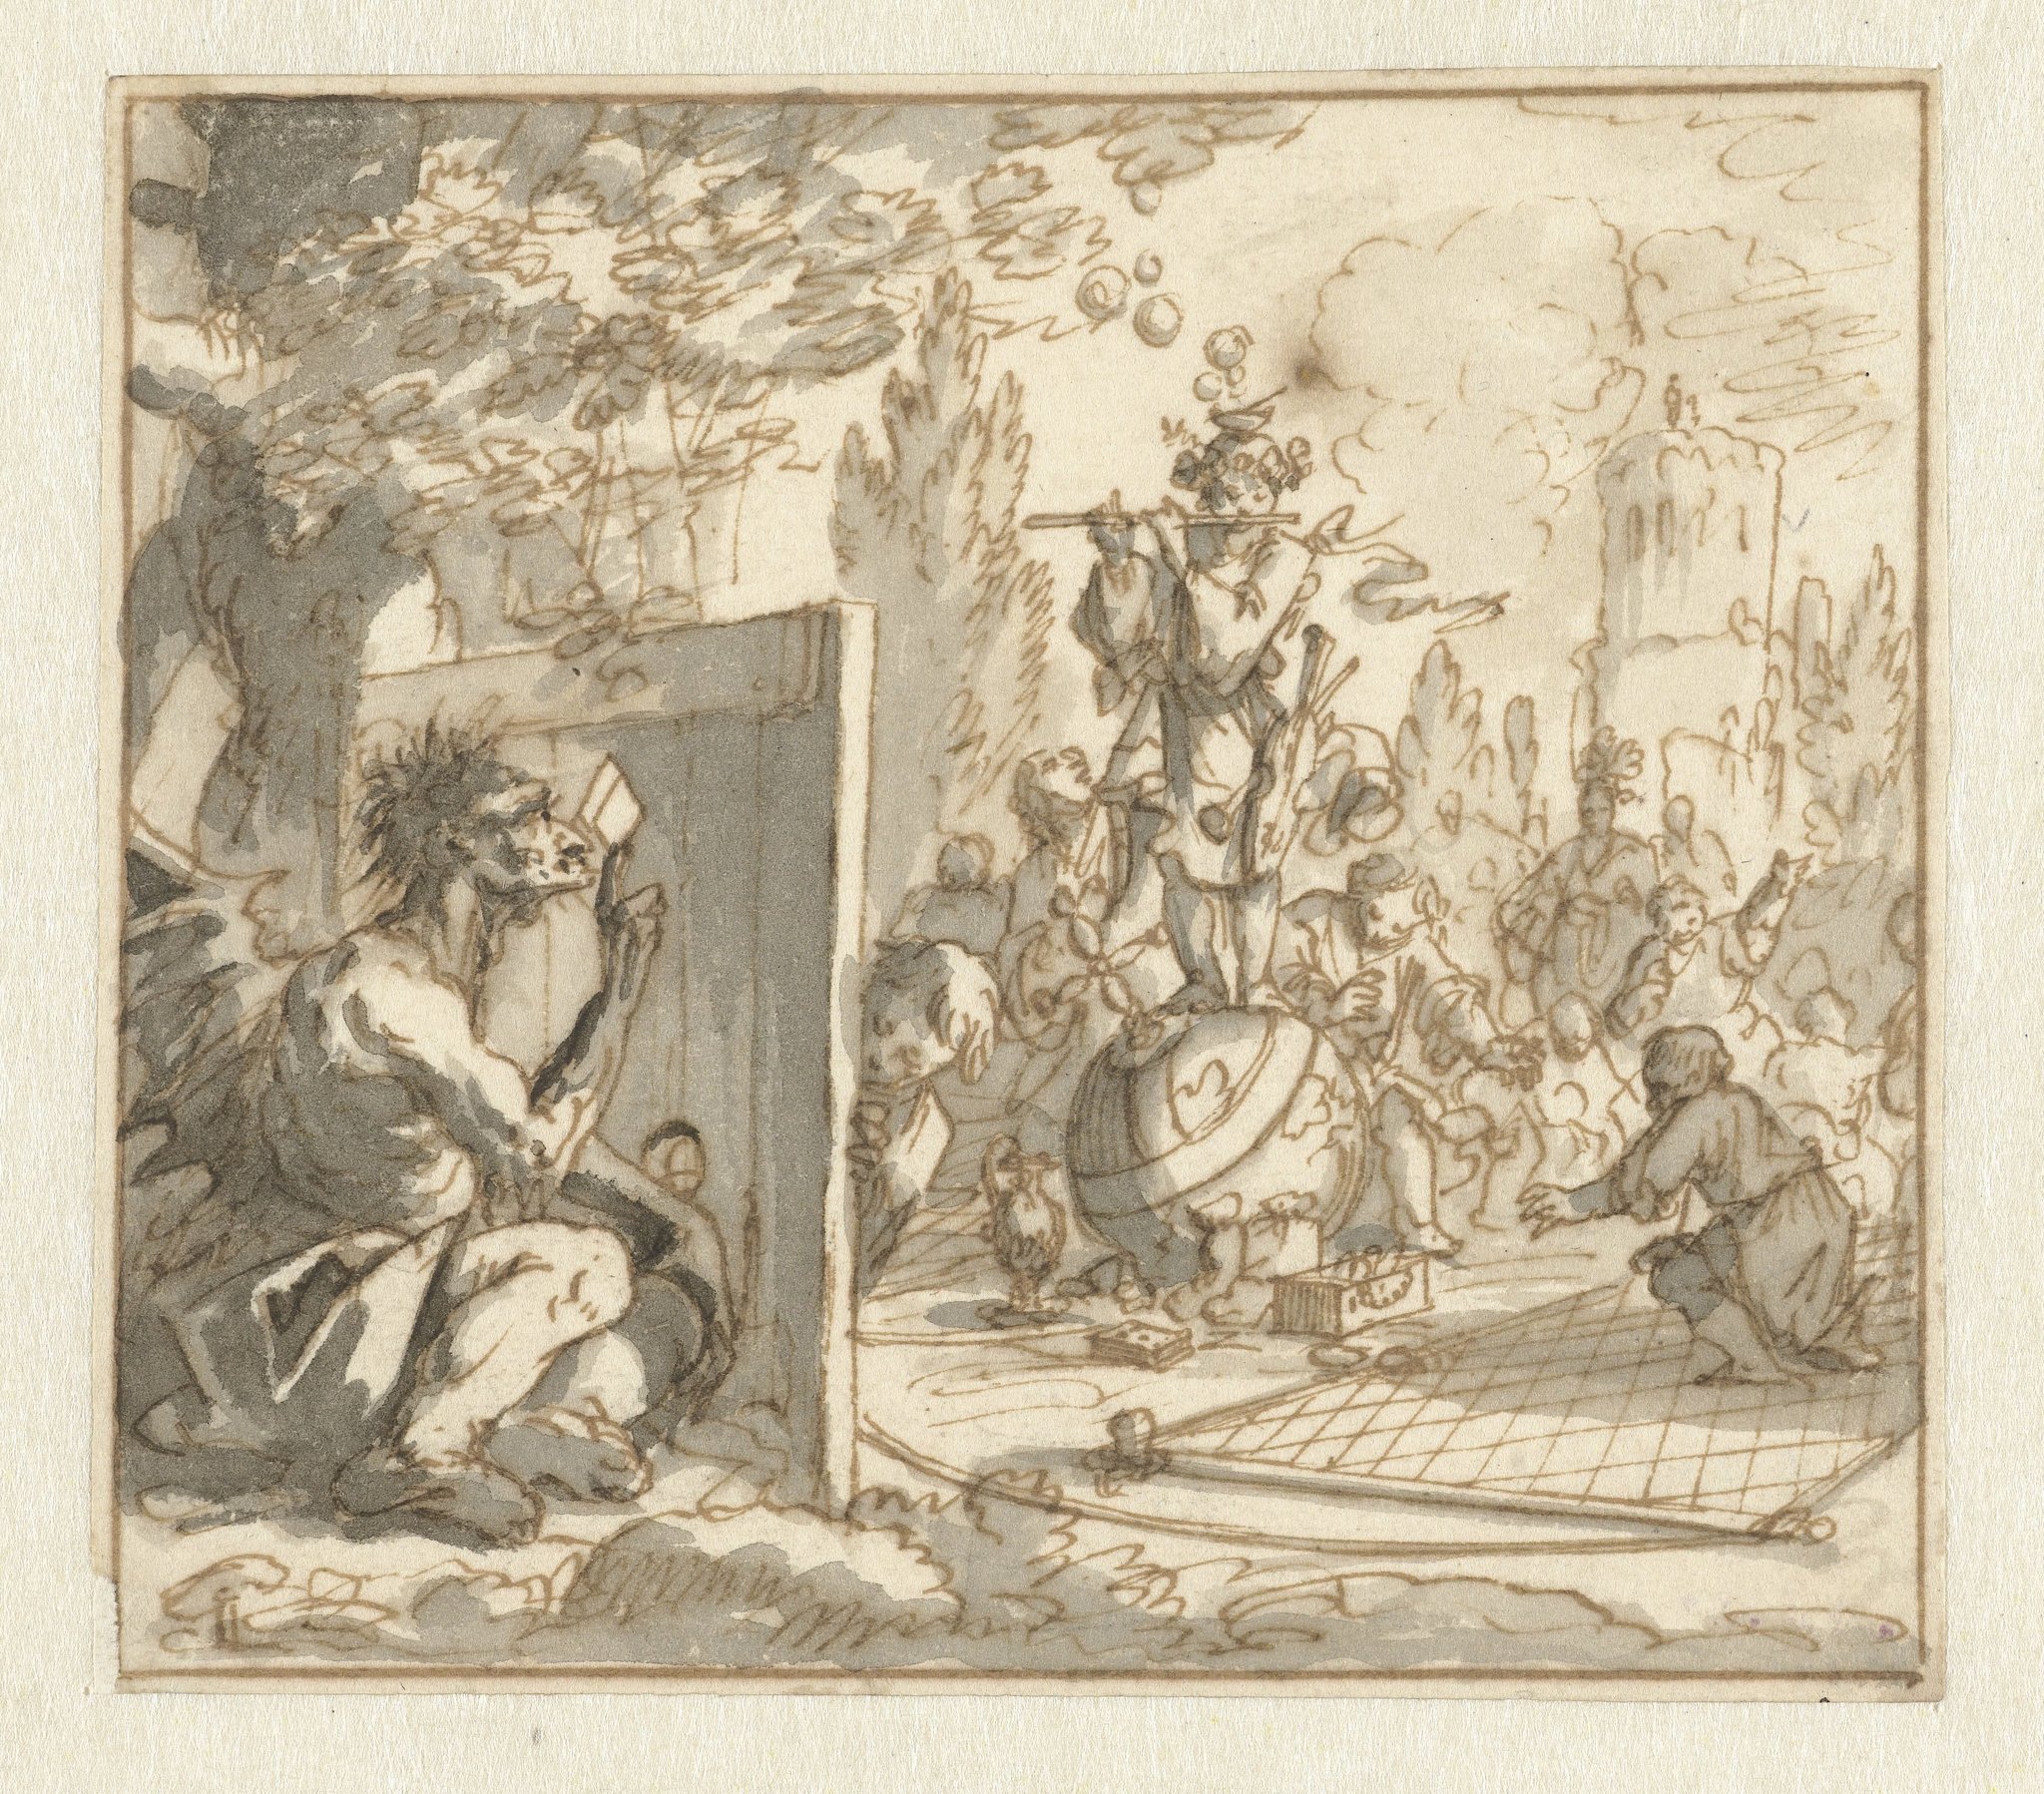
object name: drawing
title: Satan als vogelvanger met de wereld als lokaas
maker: jan luyken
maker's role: draughtsman, print maker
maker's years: 1649-1712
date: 1697-1699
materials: ink, paper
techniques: brush, pen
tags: 'musica', symbolic representations, allegories and emblems ~ music; 'musica'(ripa), scenes symbolizing 'vanitas', bird hunting, activities of devil(s)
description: Ontwerp voor illustratie in Jocelyns "Uyterste Wille van een Moeder Aan haar toekomende Kind": Schadelykheid der Weereld-Liefde.